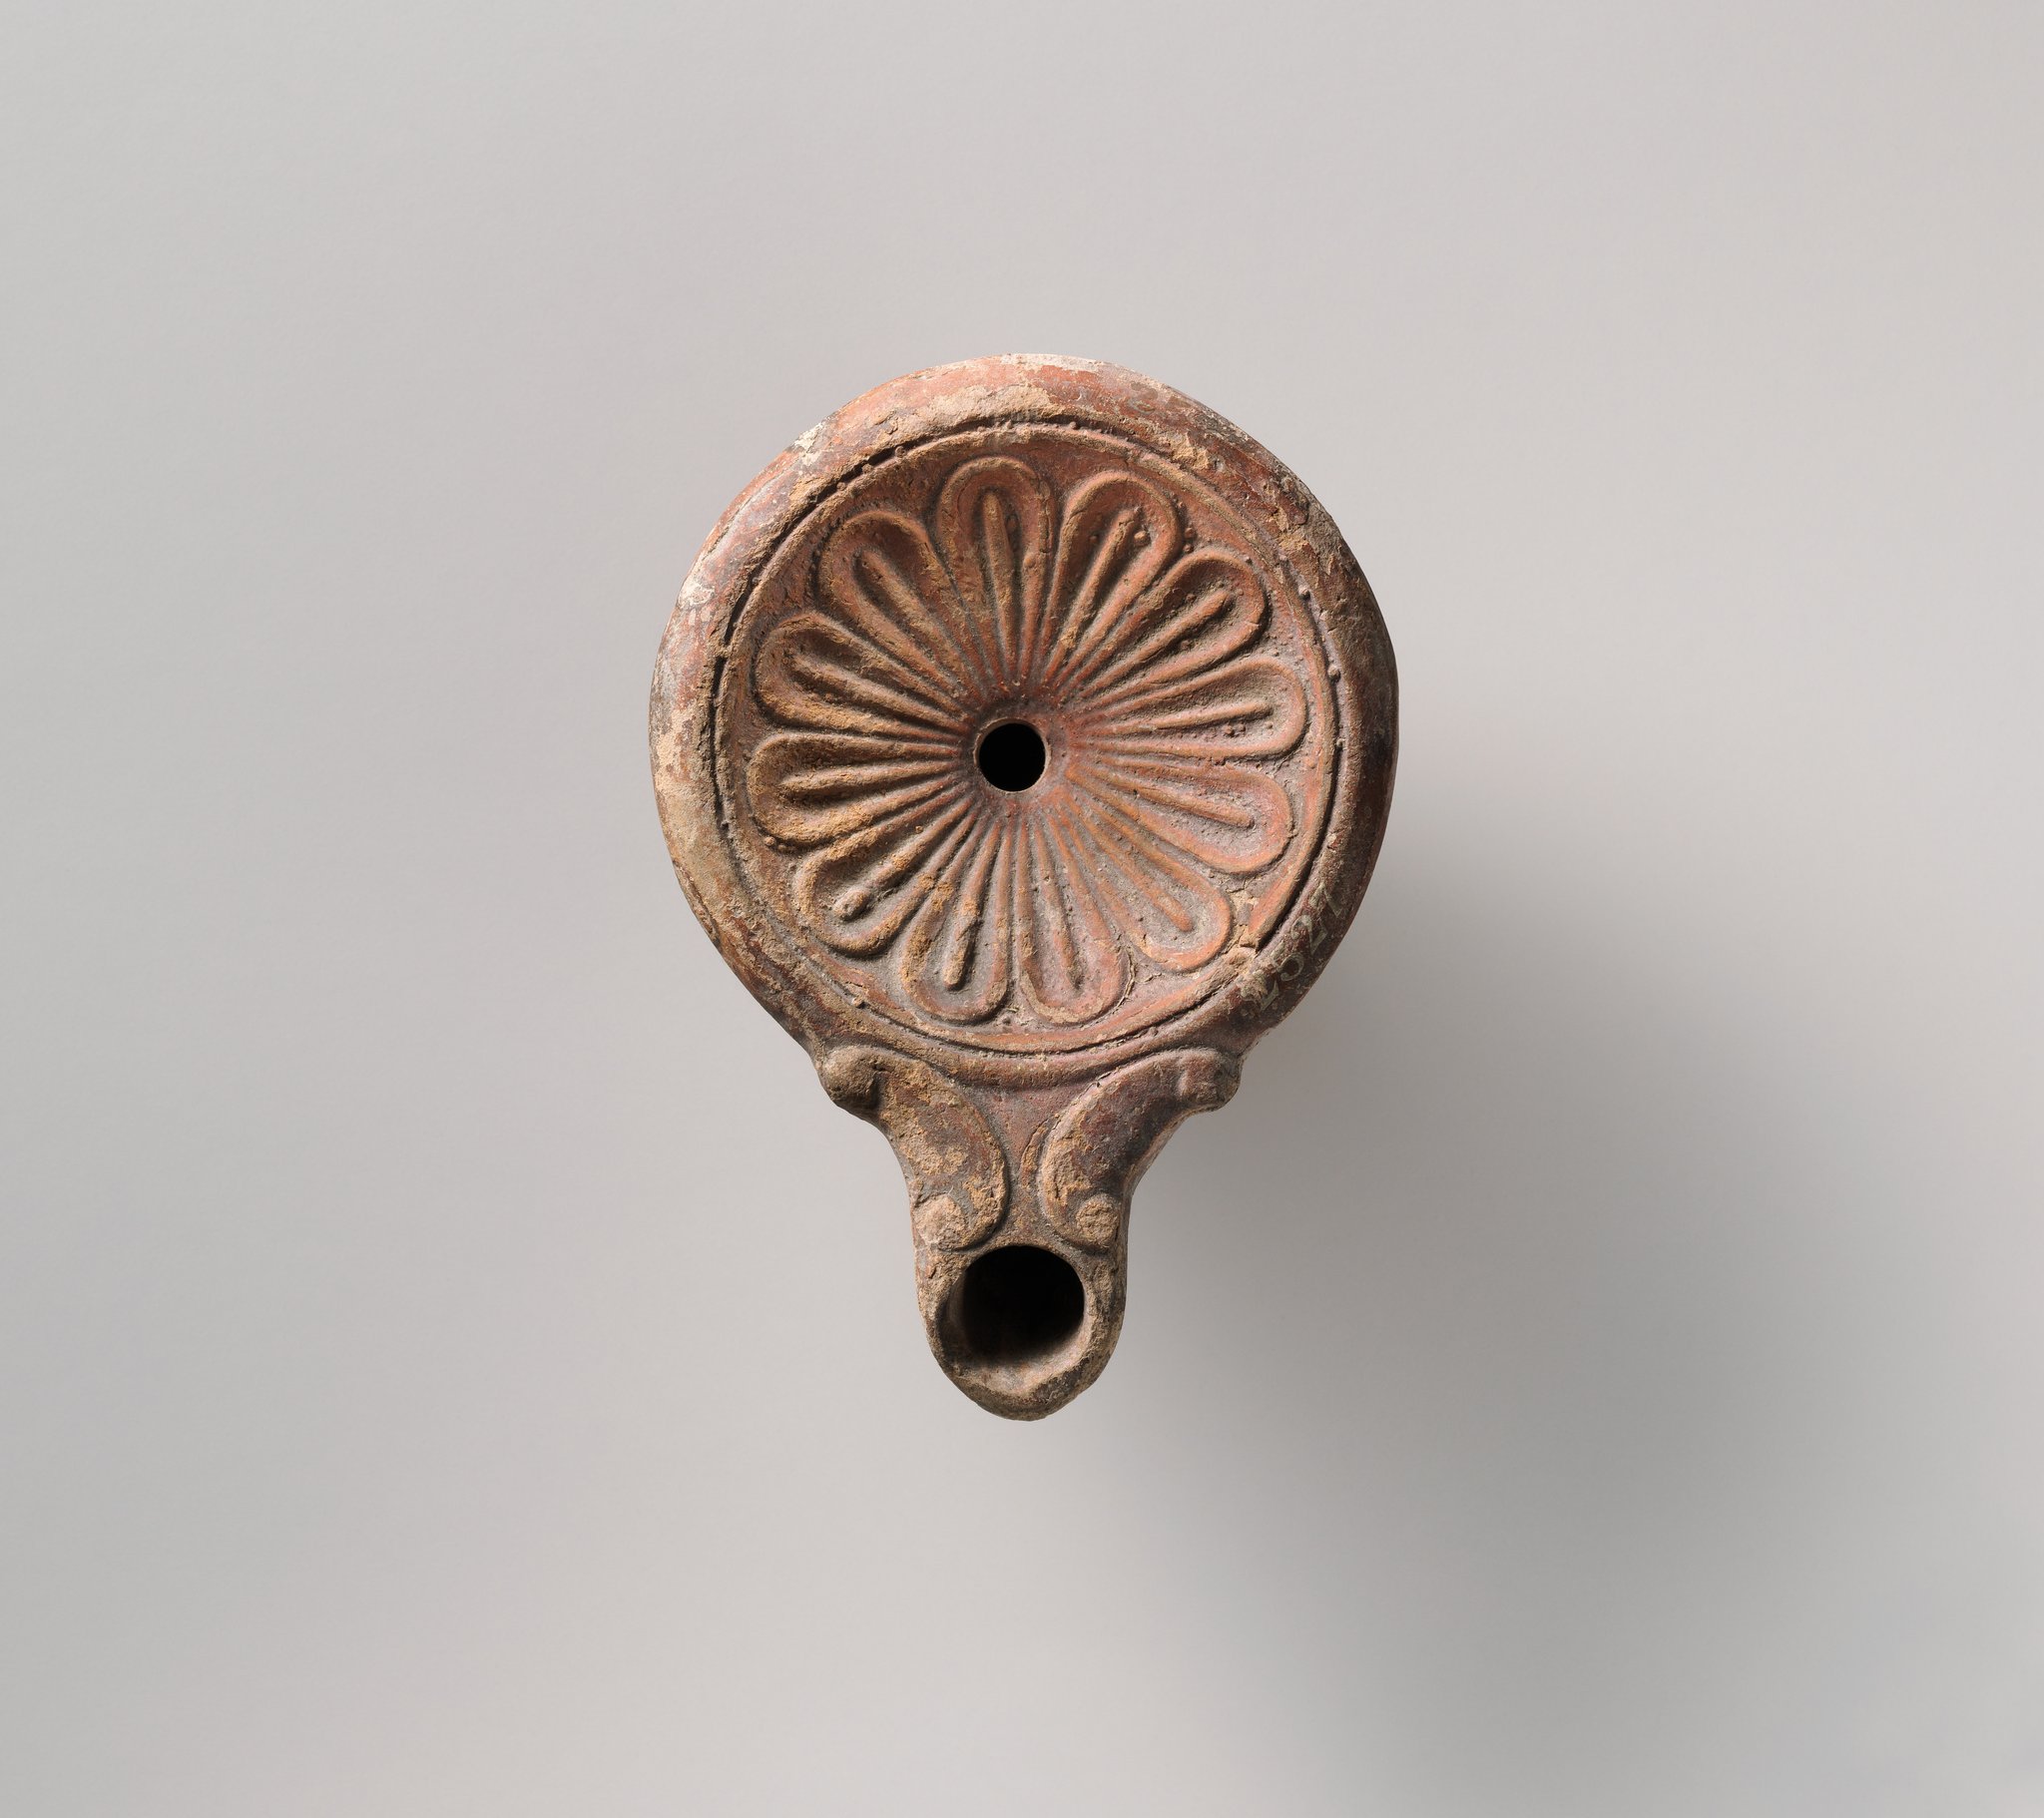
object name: lamp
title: Tarracotta oil lamp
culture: roman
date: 40-100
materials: terracotta